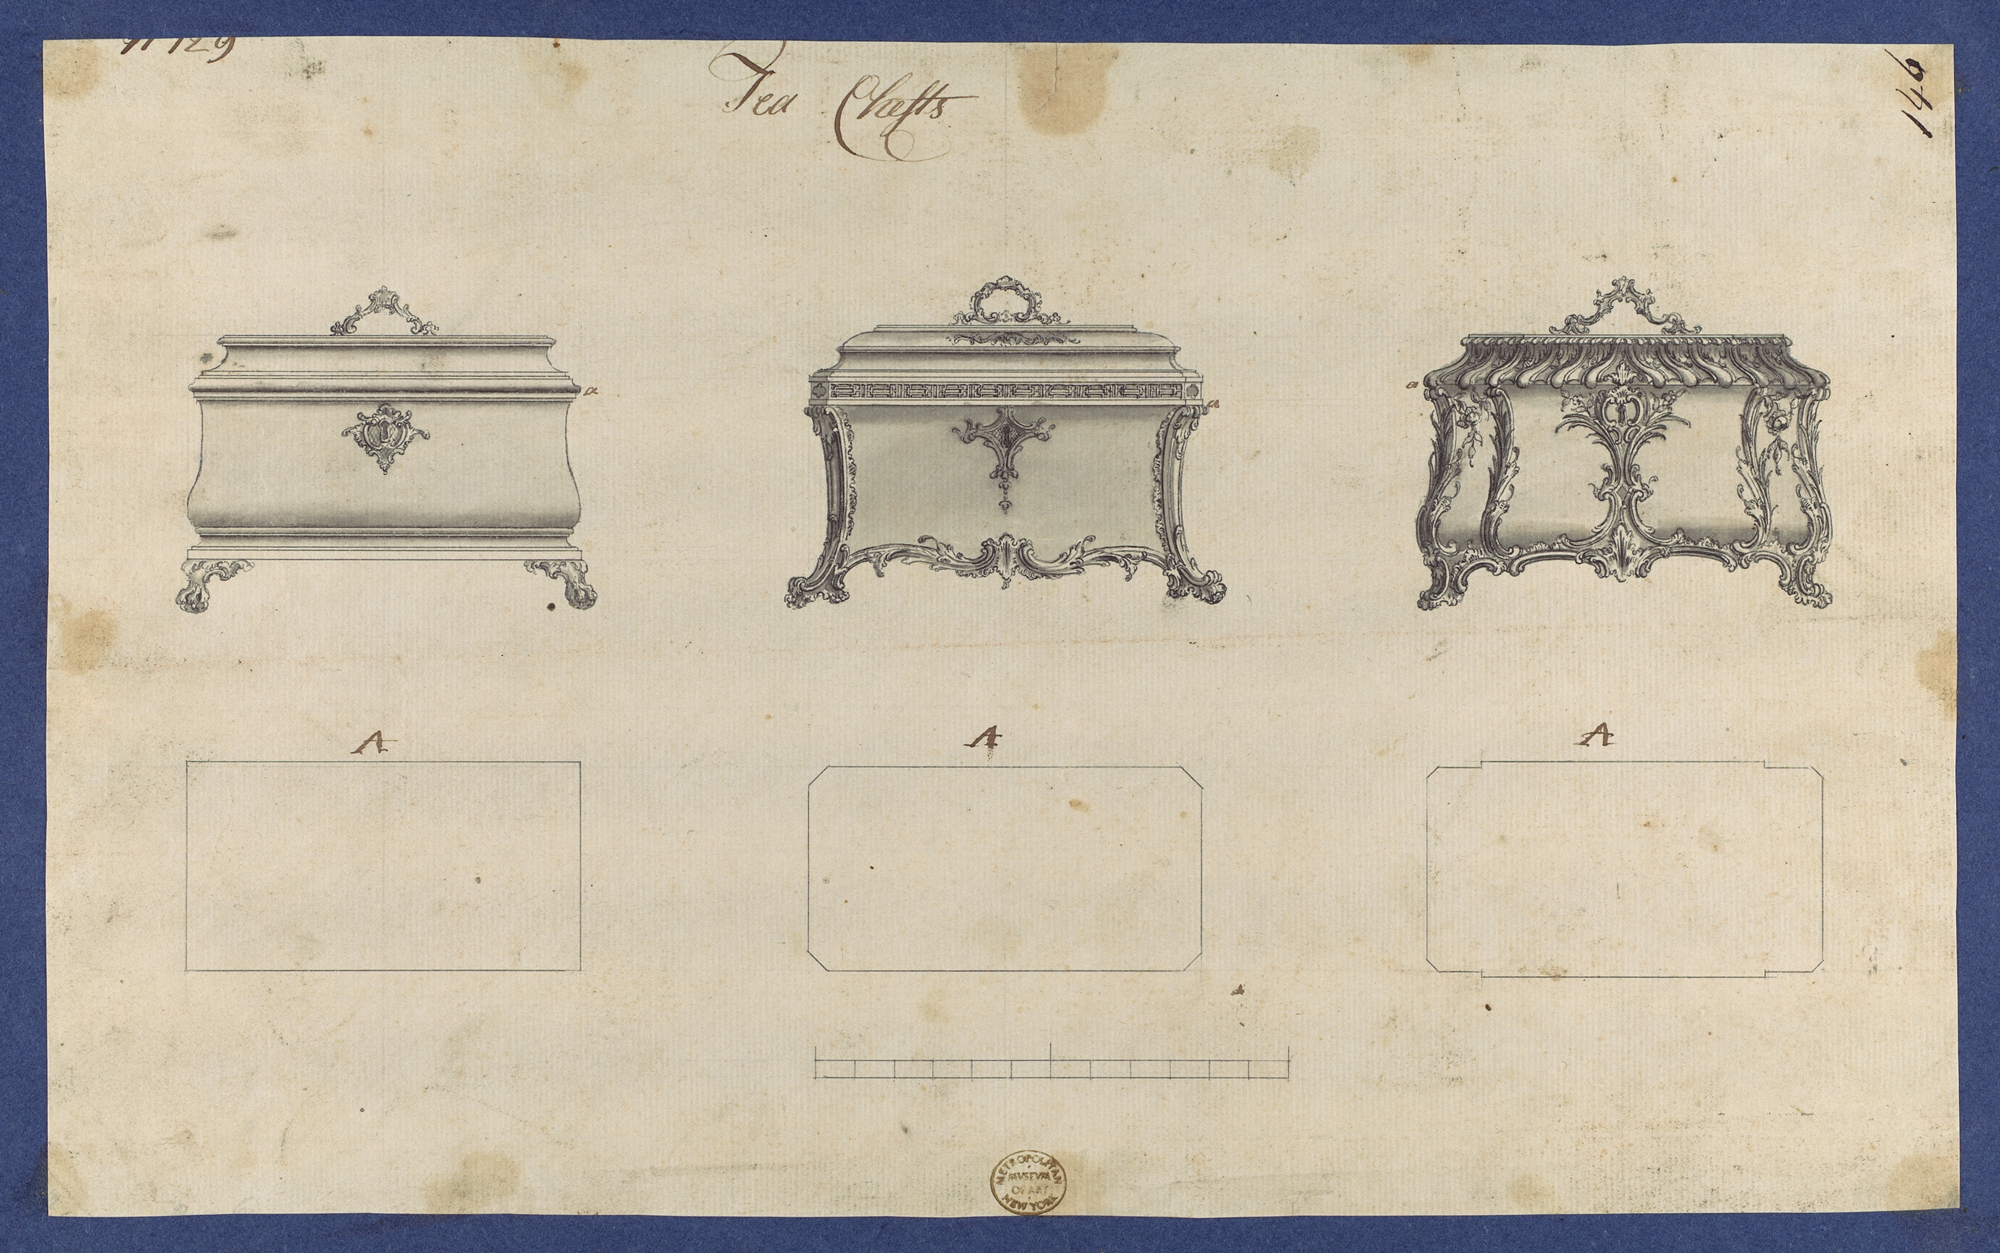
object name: drawing ornament architecture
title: Tea Chests, in Chippendale Drawings, Vol. I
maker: thomas chippendale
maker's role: artist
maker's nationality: british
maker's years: 1718-1779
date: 1754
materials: ink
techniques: wash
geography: london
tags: chests